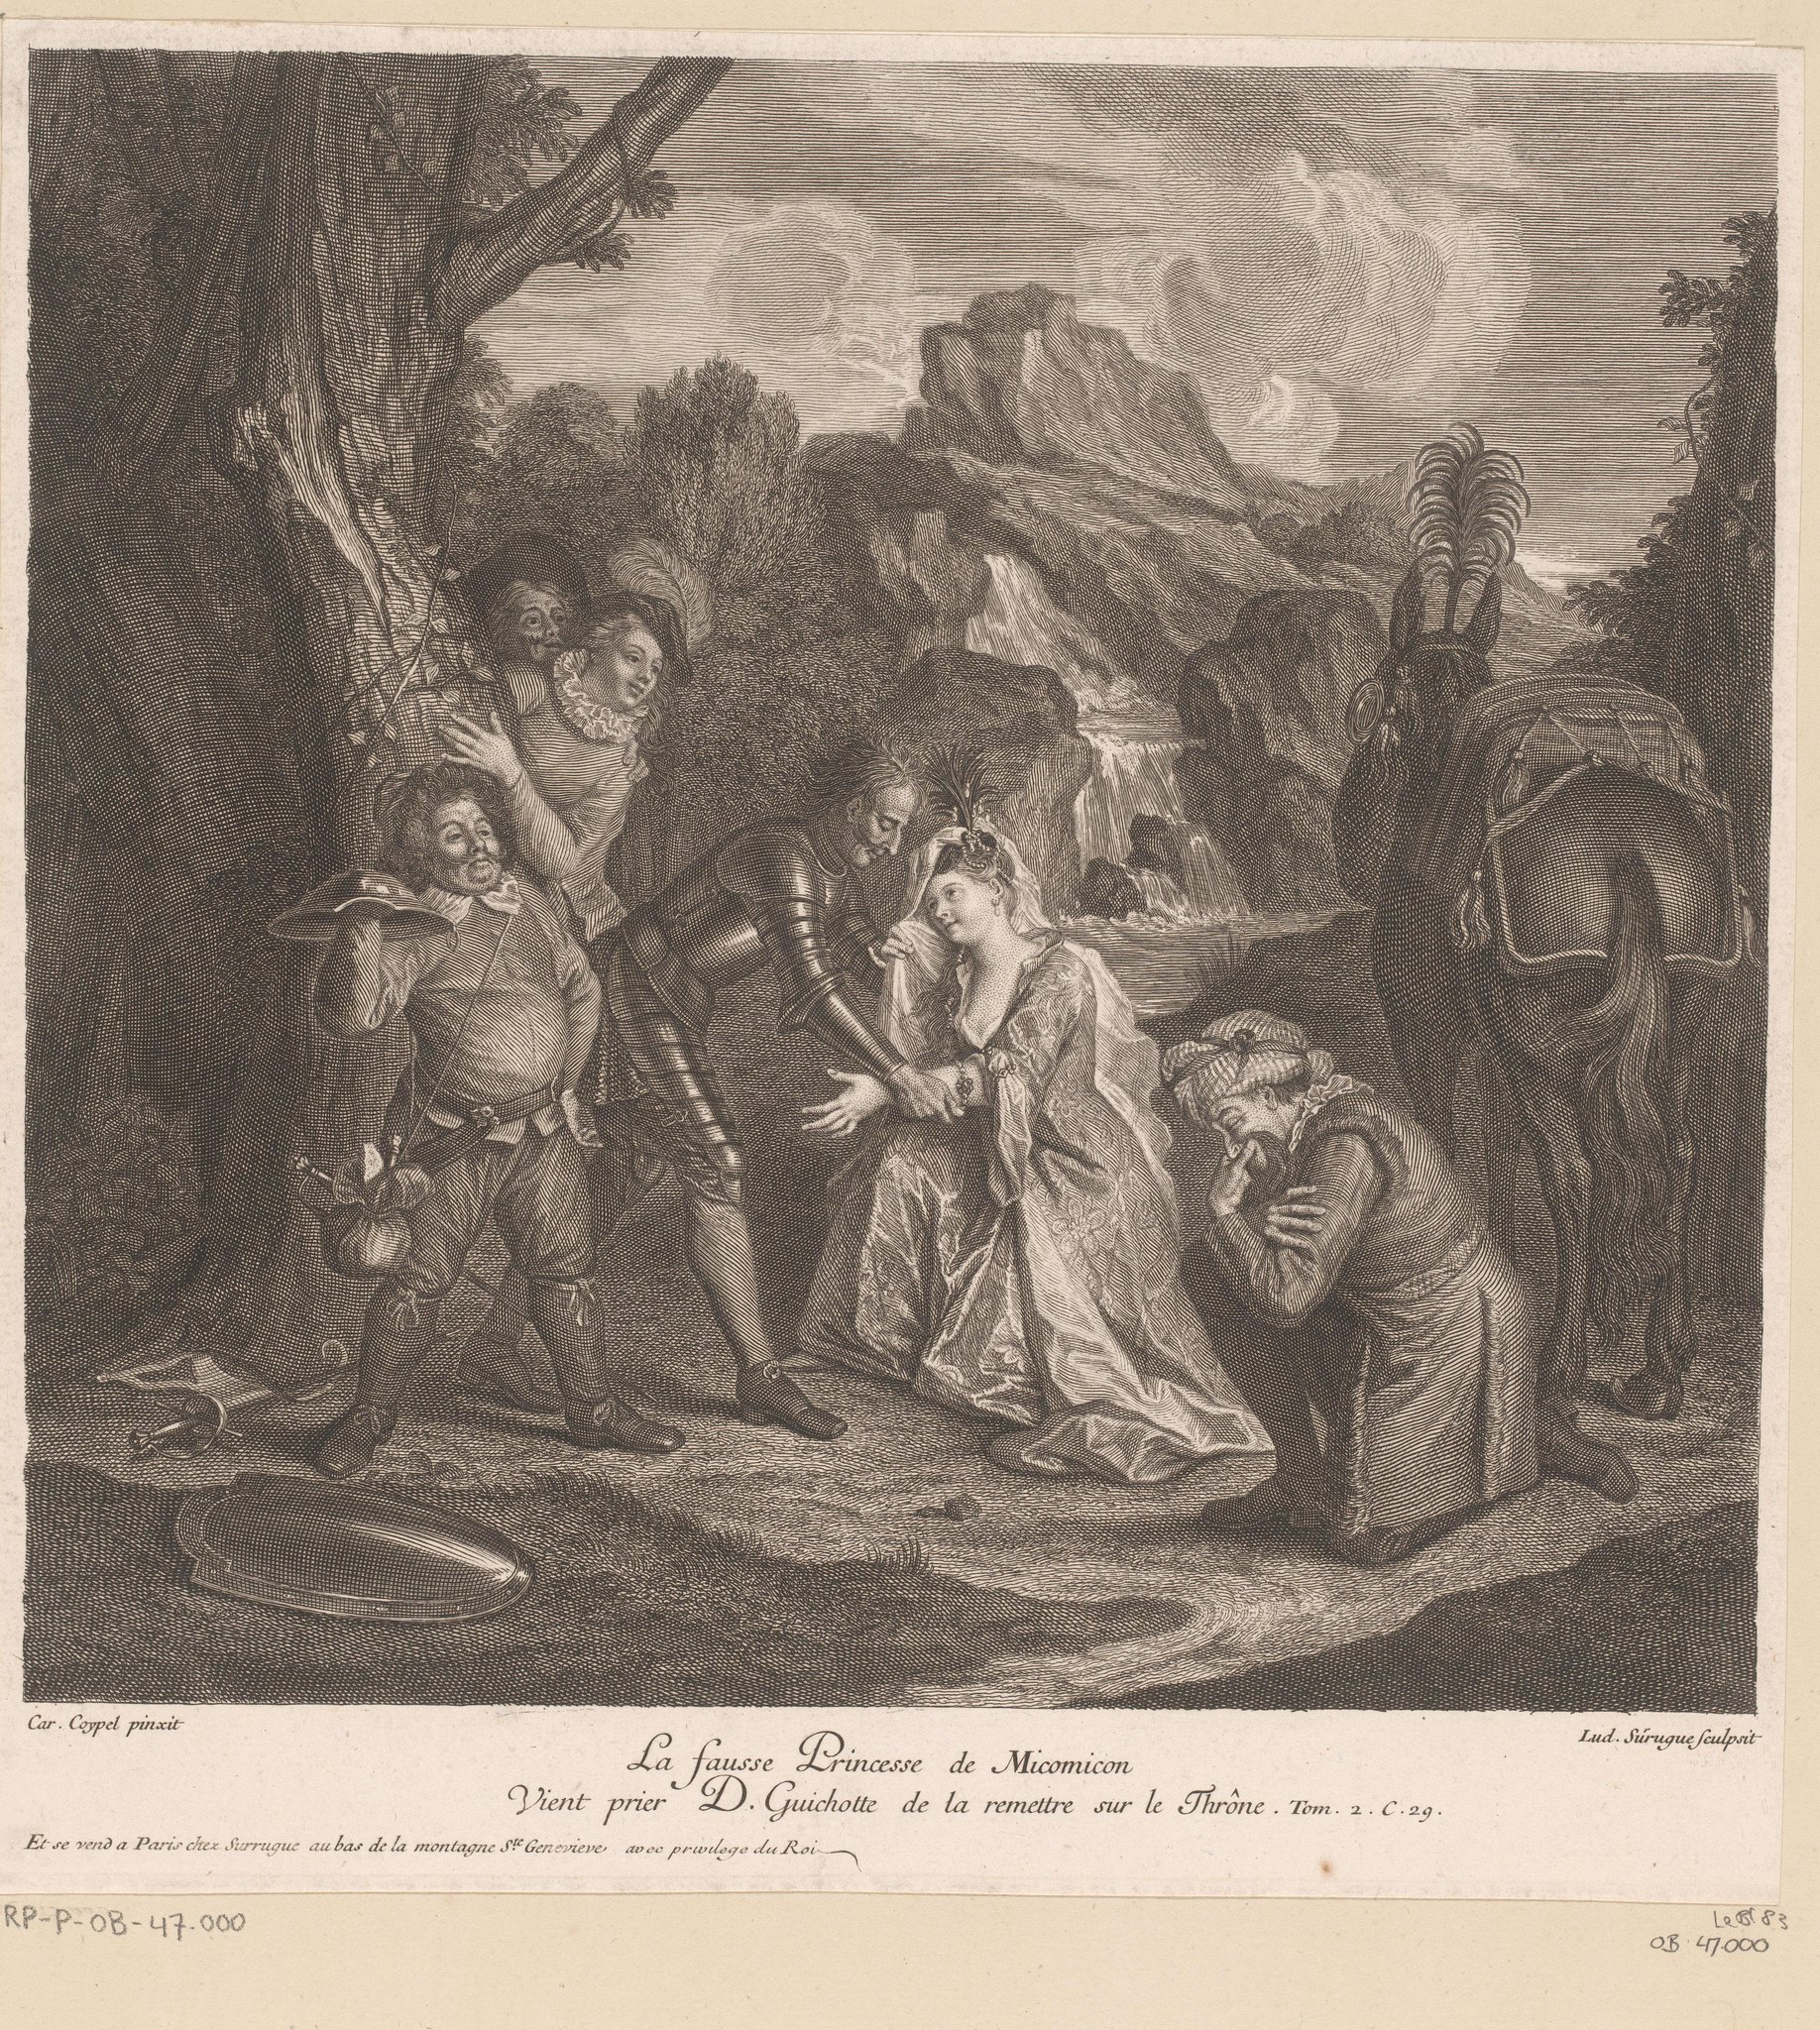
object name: print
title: Gechiedenis van Don Quichot van La Mancha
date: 1691-1767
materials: paper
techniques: engraving, etching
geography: paris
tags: don quixote, sancho panza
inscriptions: collector's mark: Lugt 240